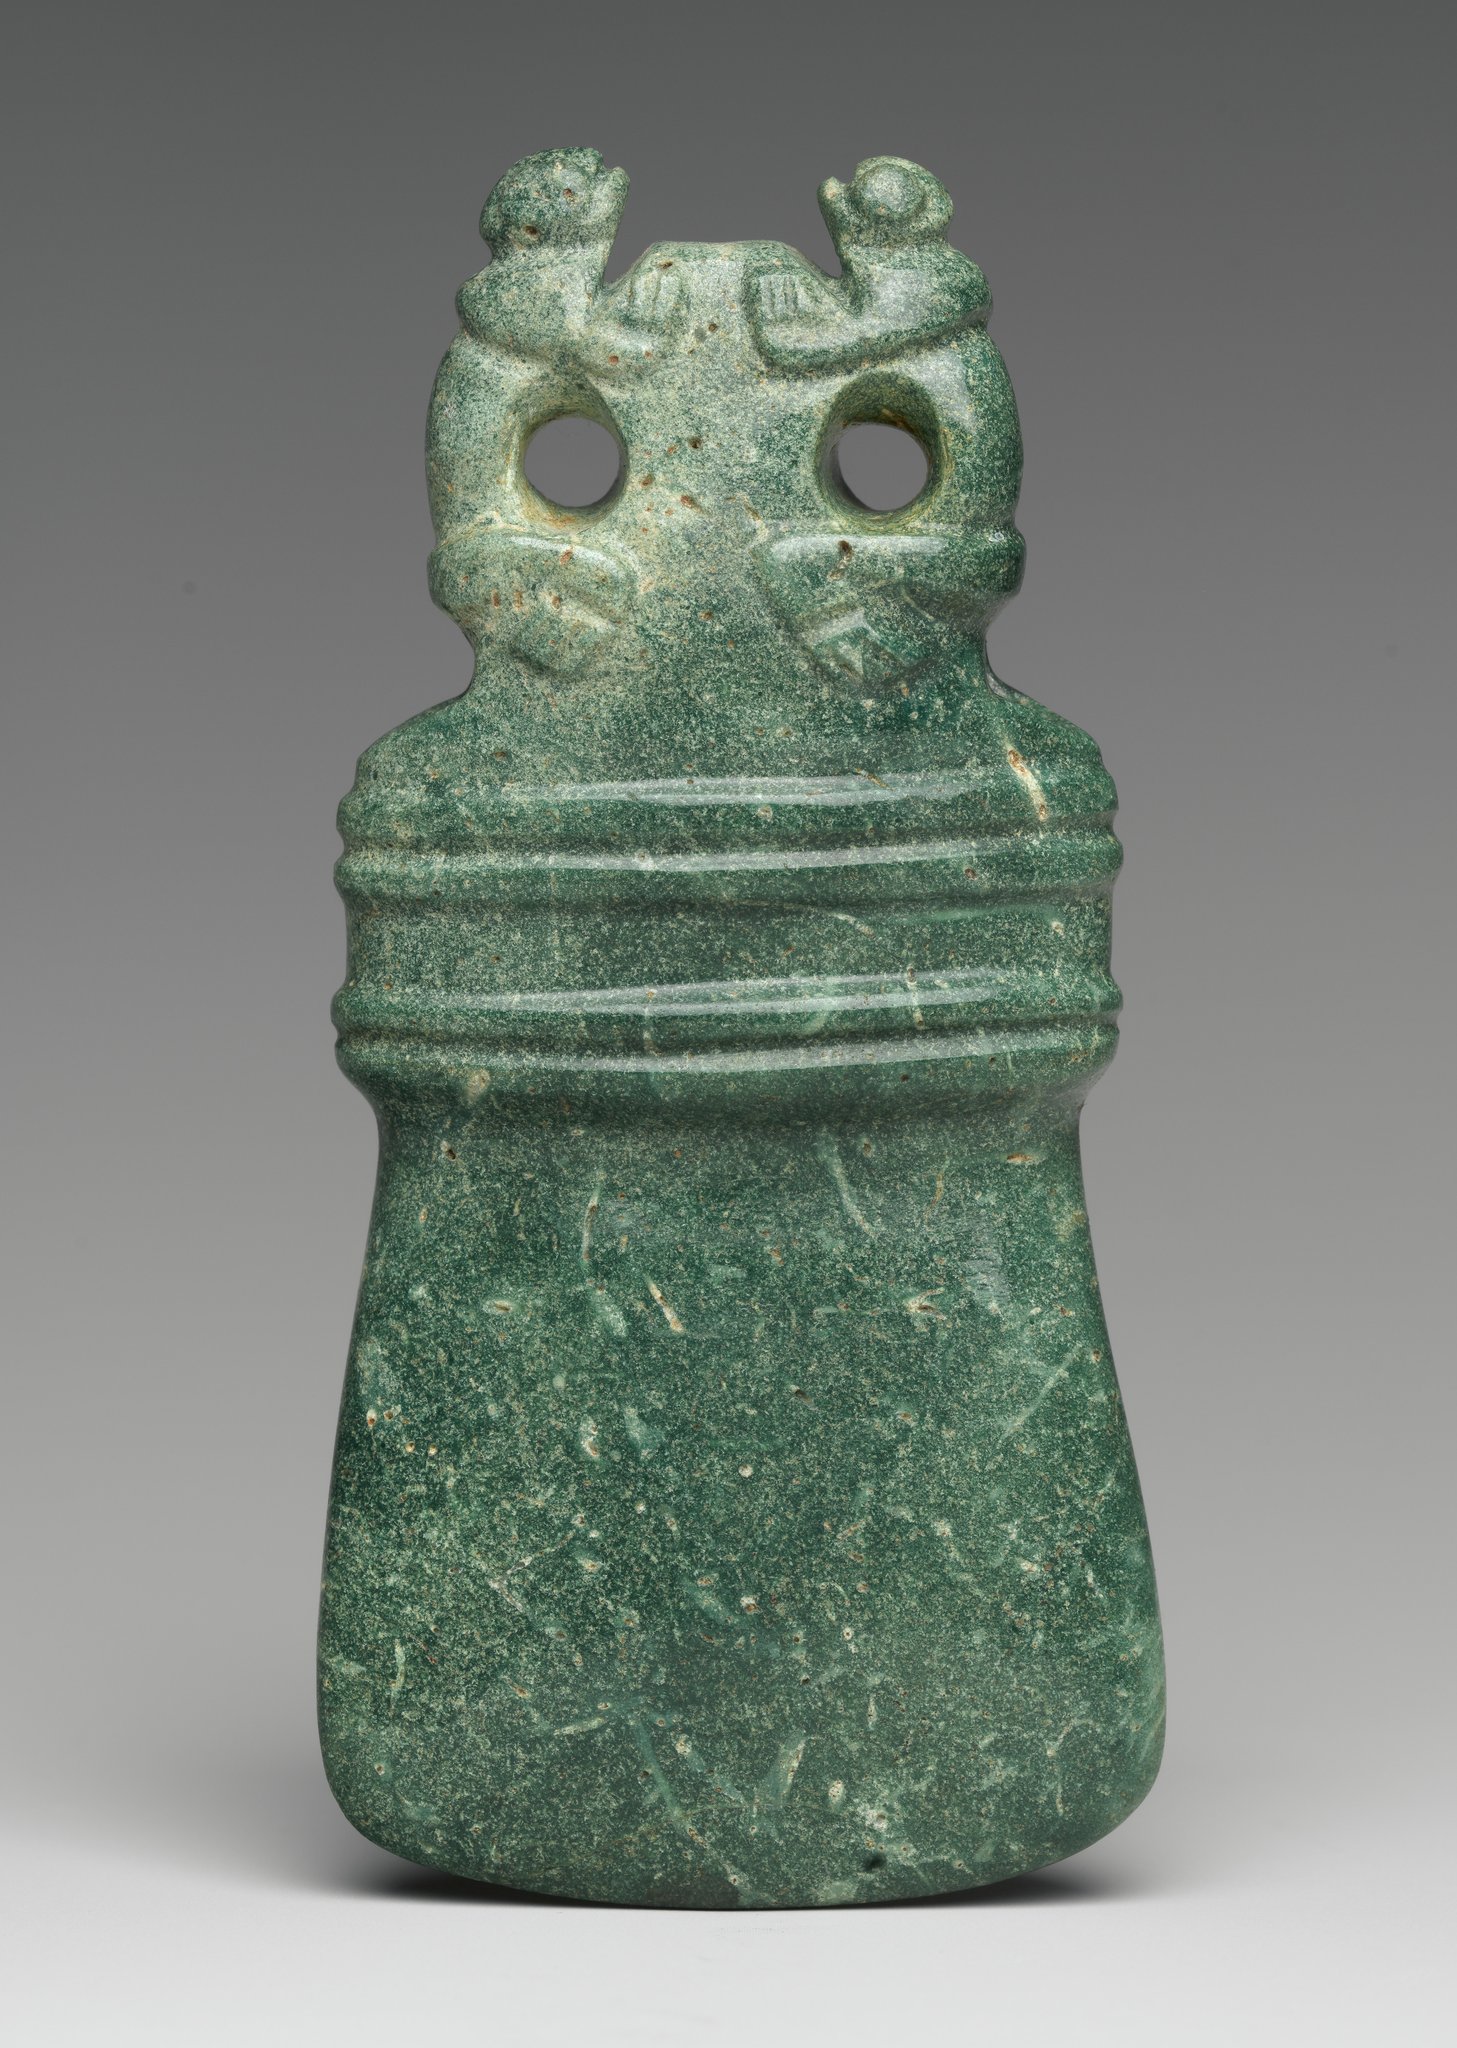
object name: pendant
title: Celt pendant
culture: guanacaste-nicoya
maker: greater nicoya or central region artitst(s)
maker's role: artist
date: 1-500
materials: jade, quartz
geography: costa rica